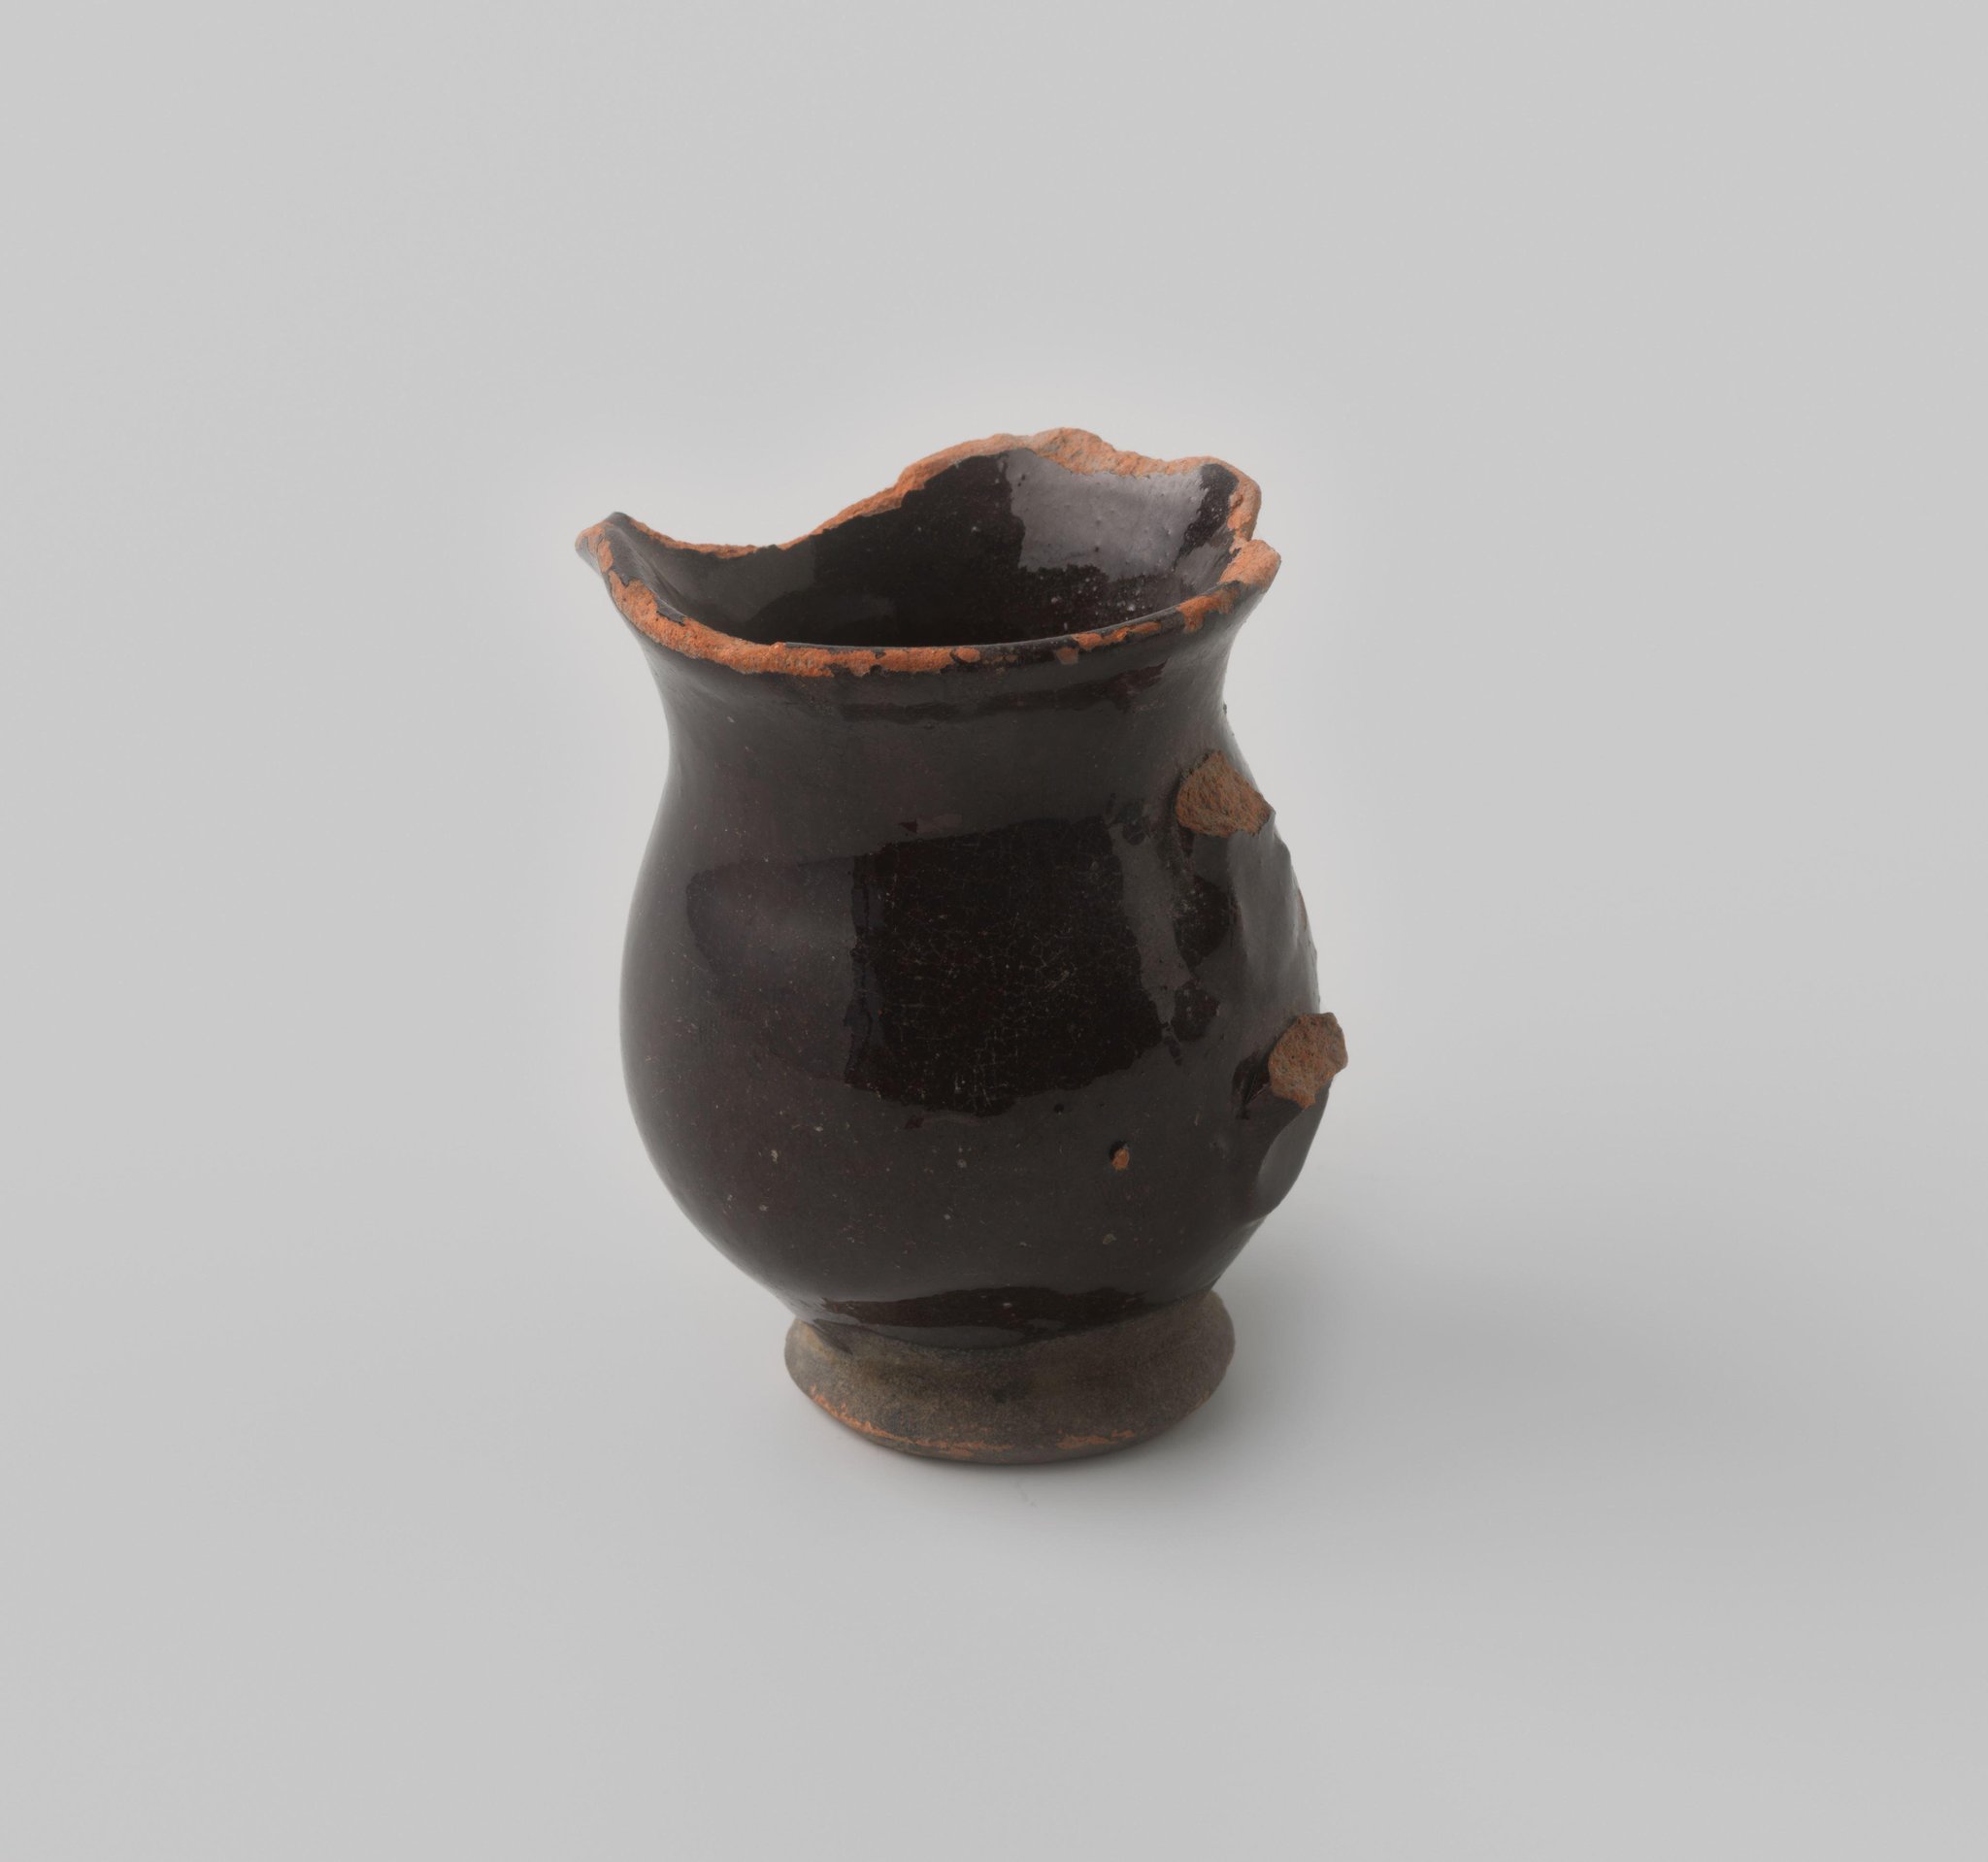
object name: fragment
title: Kan, beschadigd, van roodbakkend aardewerk voorzien van bruine glazuur aan de binnen- en buitenzijde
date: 1500-1899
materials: earthenware, glaze